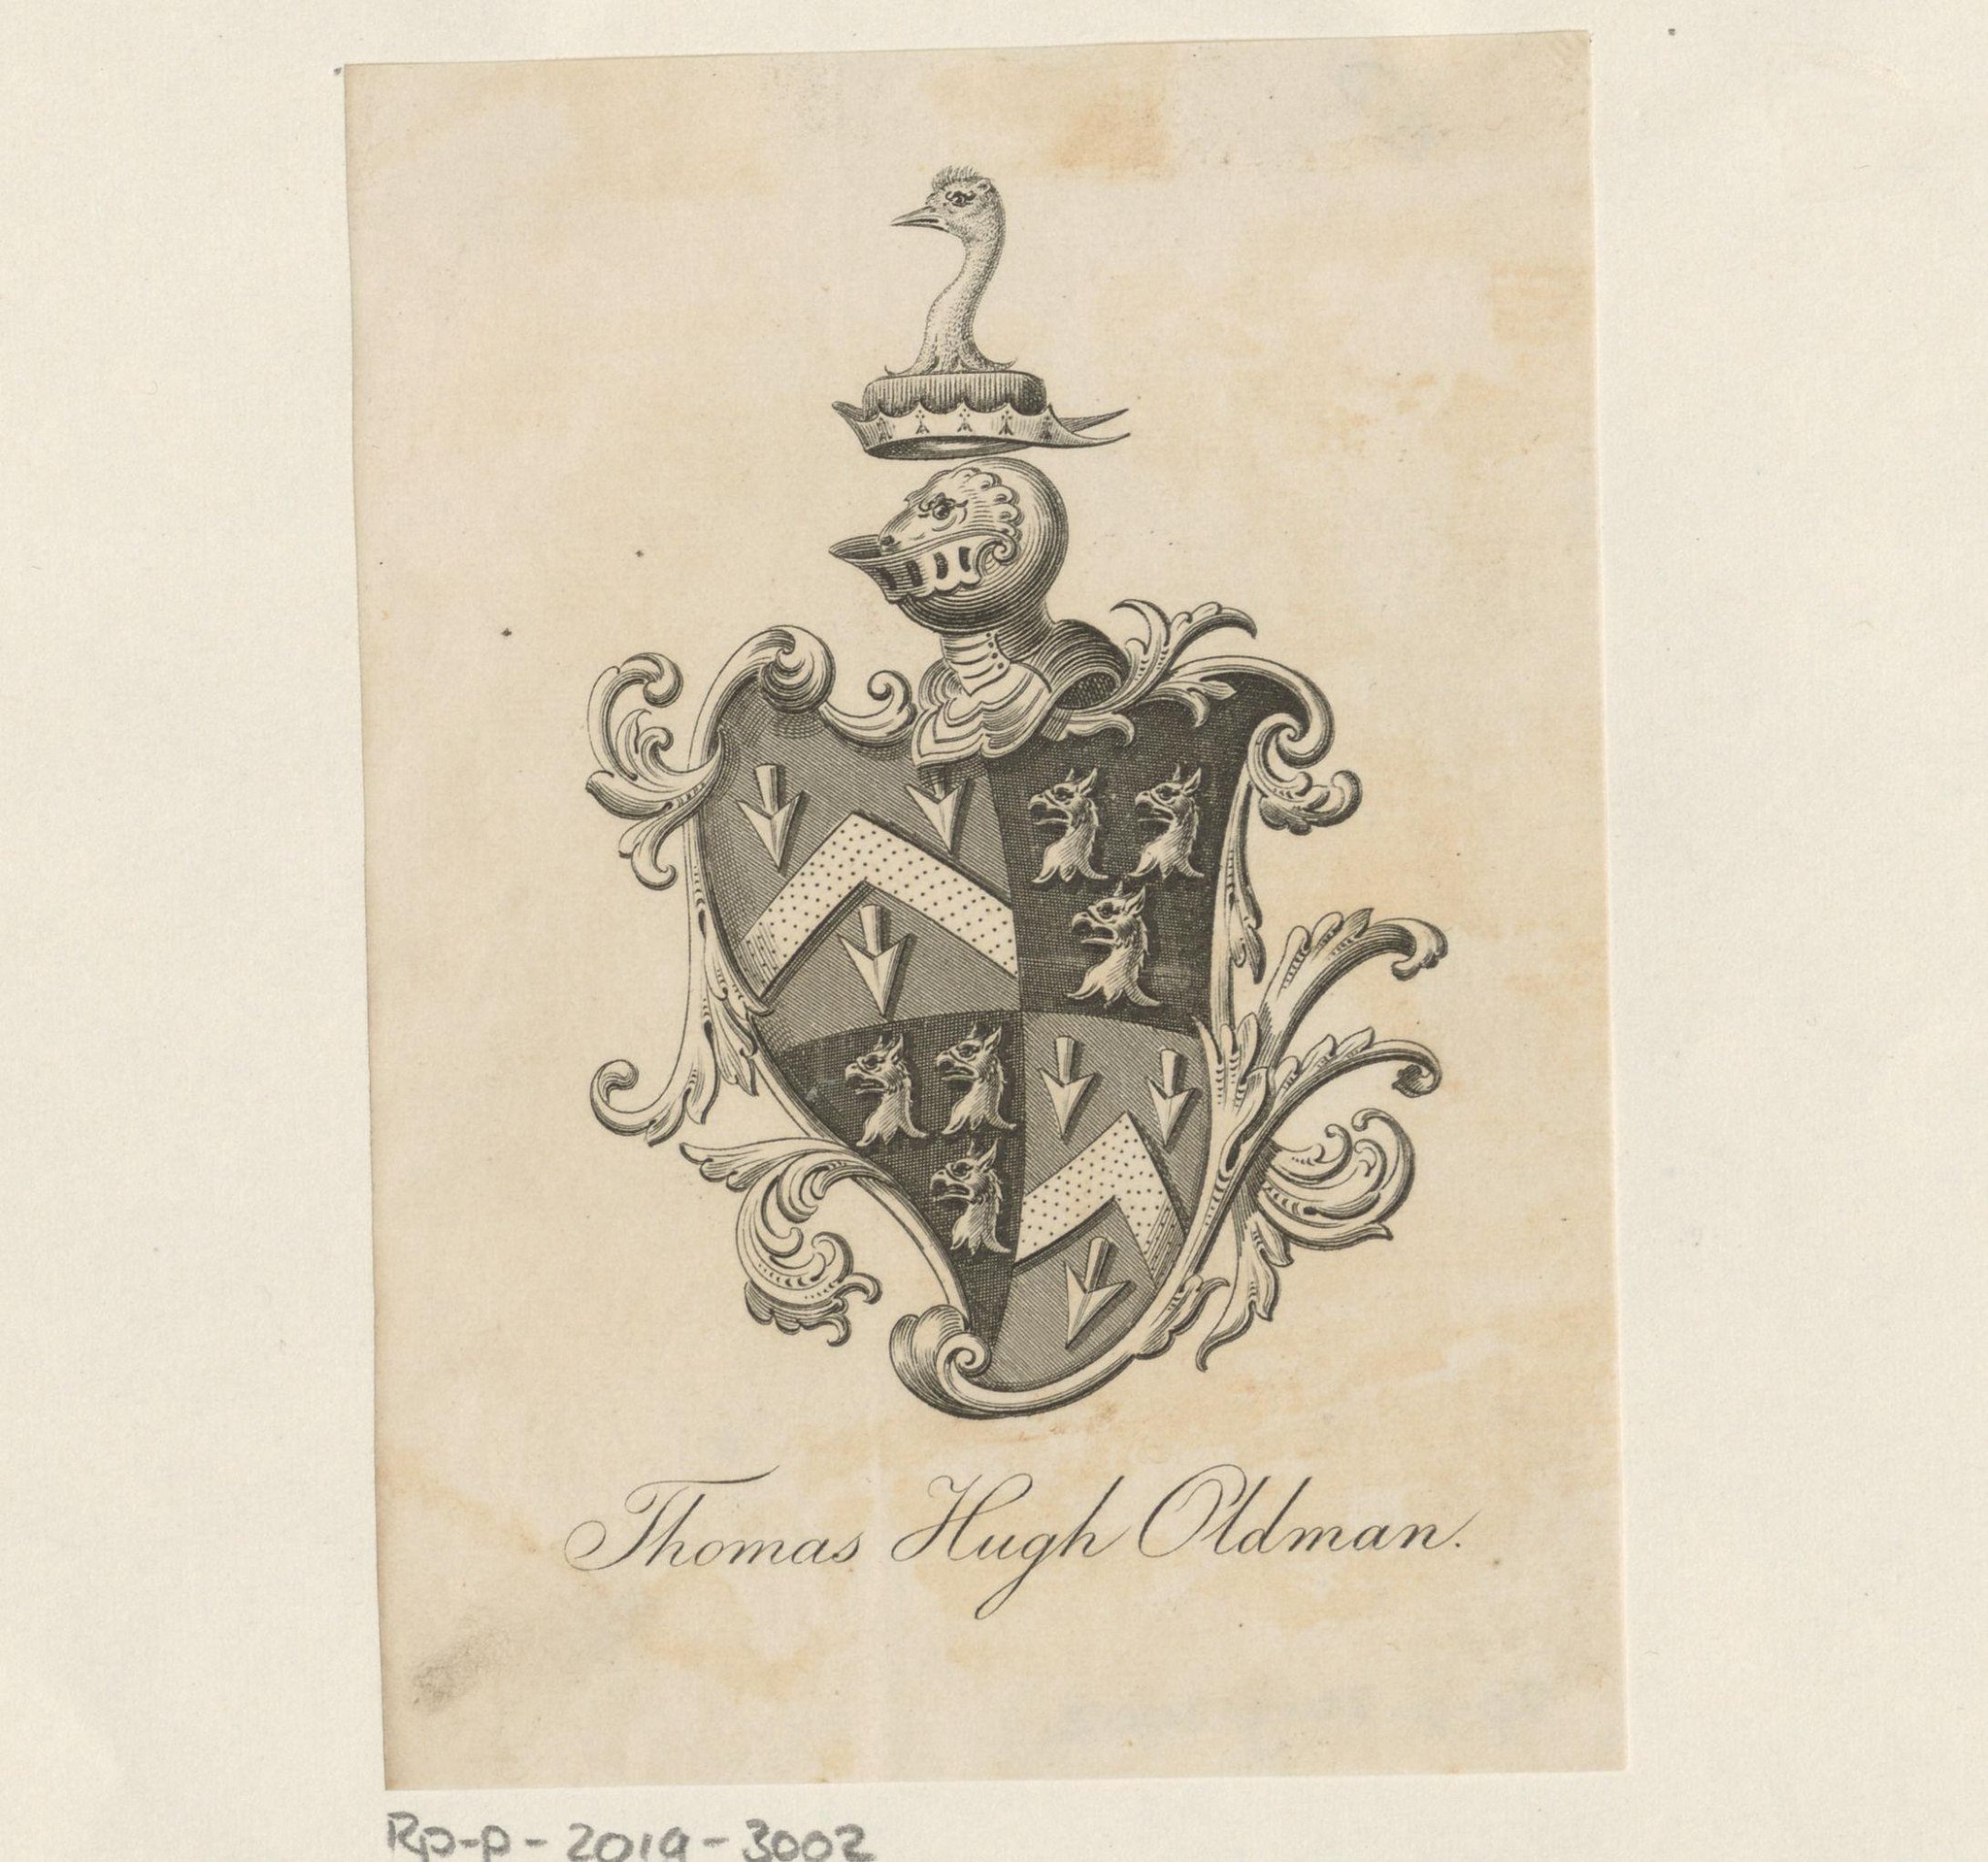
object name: bookplate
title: Ex libris van Thomas Hugh Oldman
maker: Anonymous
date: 1800-1899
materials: paper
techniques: engraving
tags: armorial bearing, heraldry